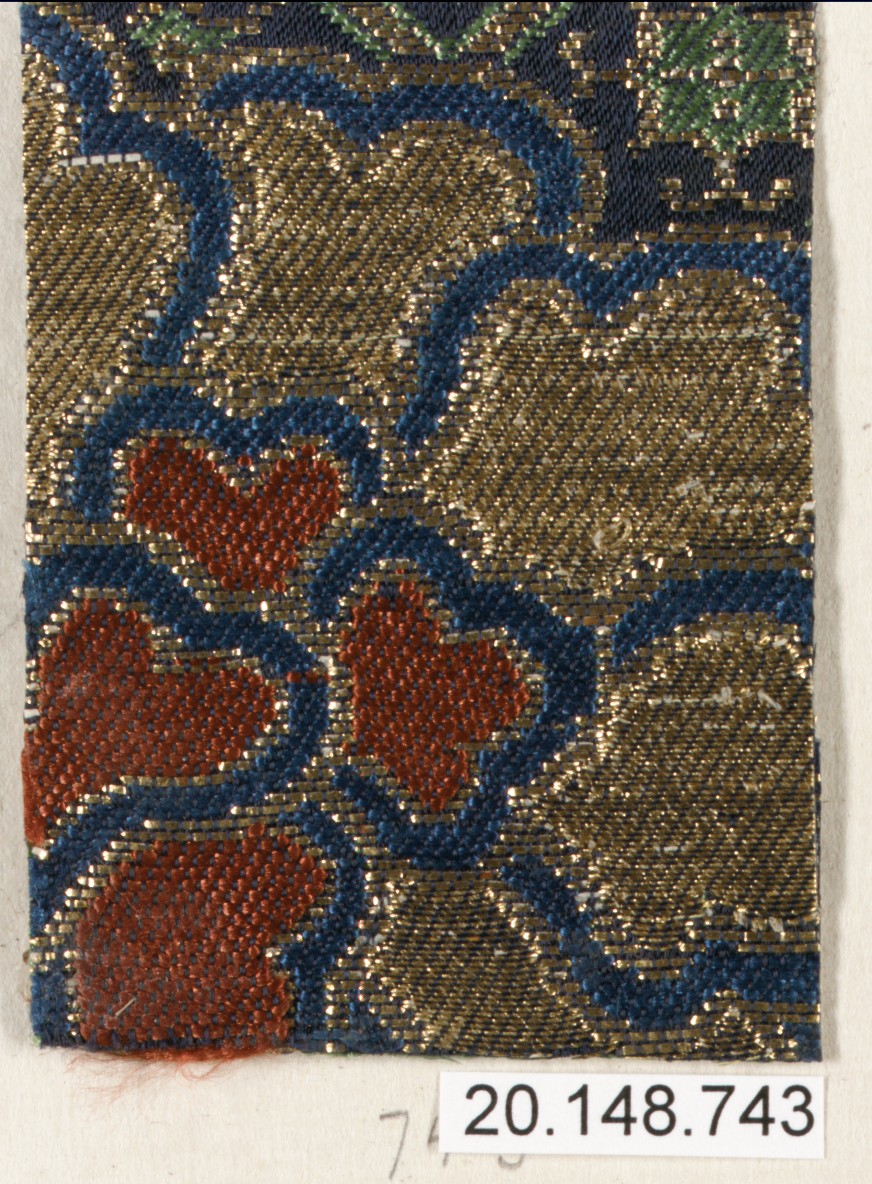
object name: piece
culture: japanese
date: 1601-1700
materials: silk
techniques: compound weave